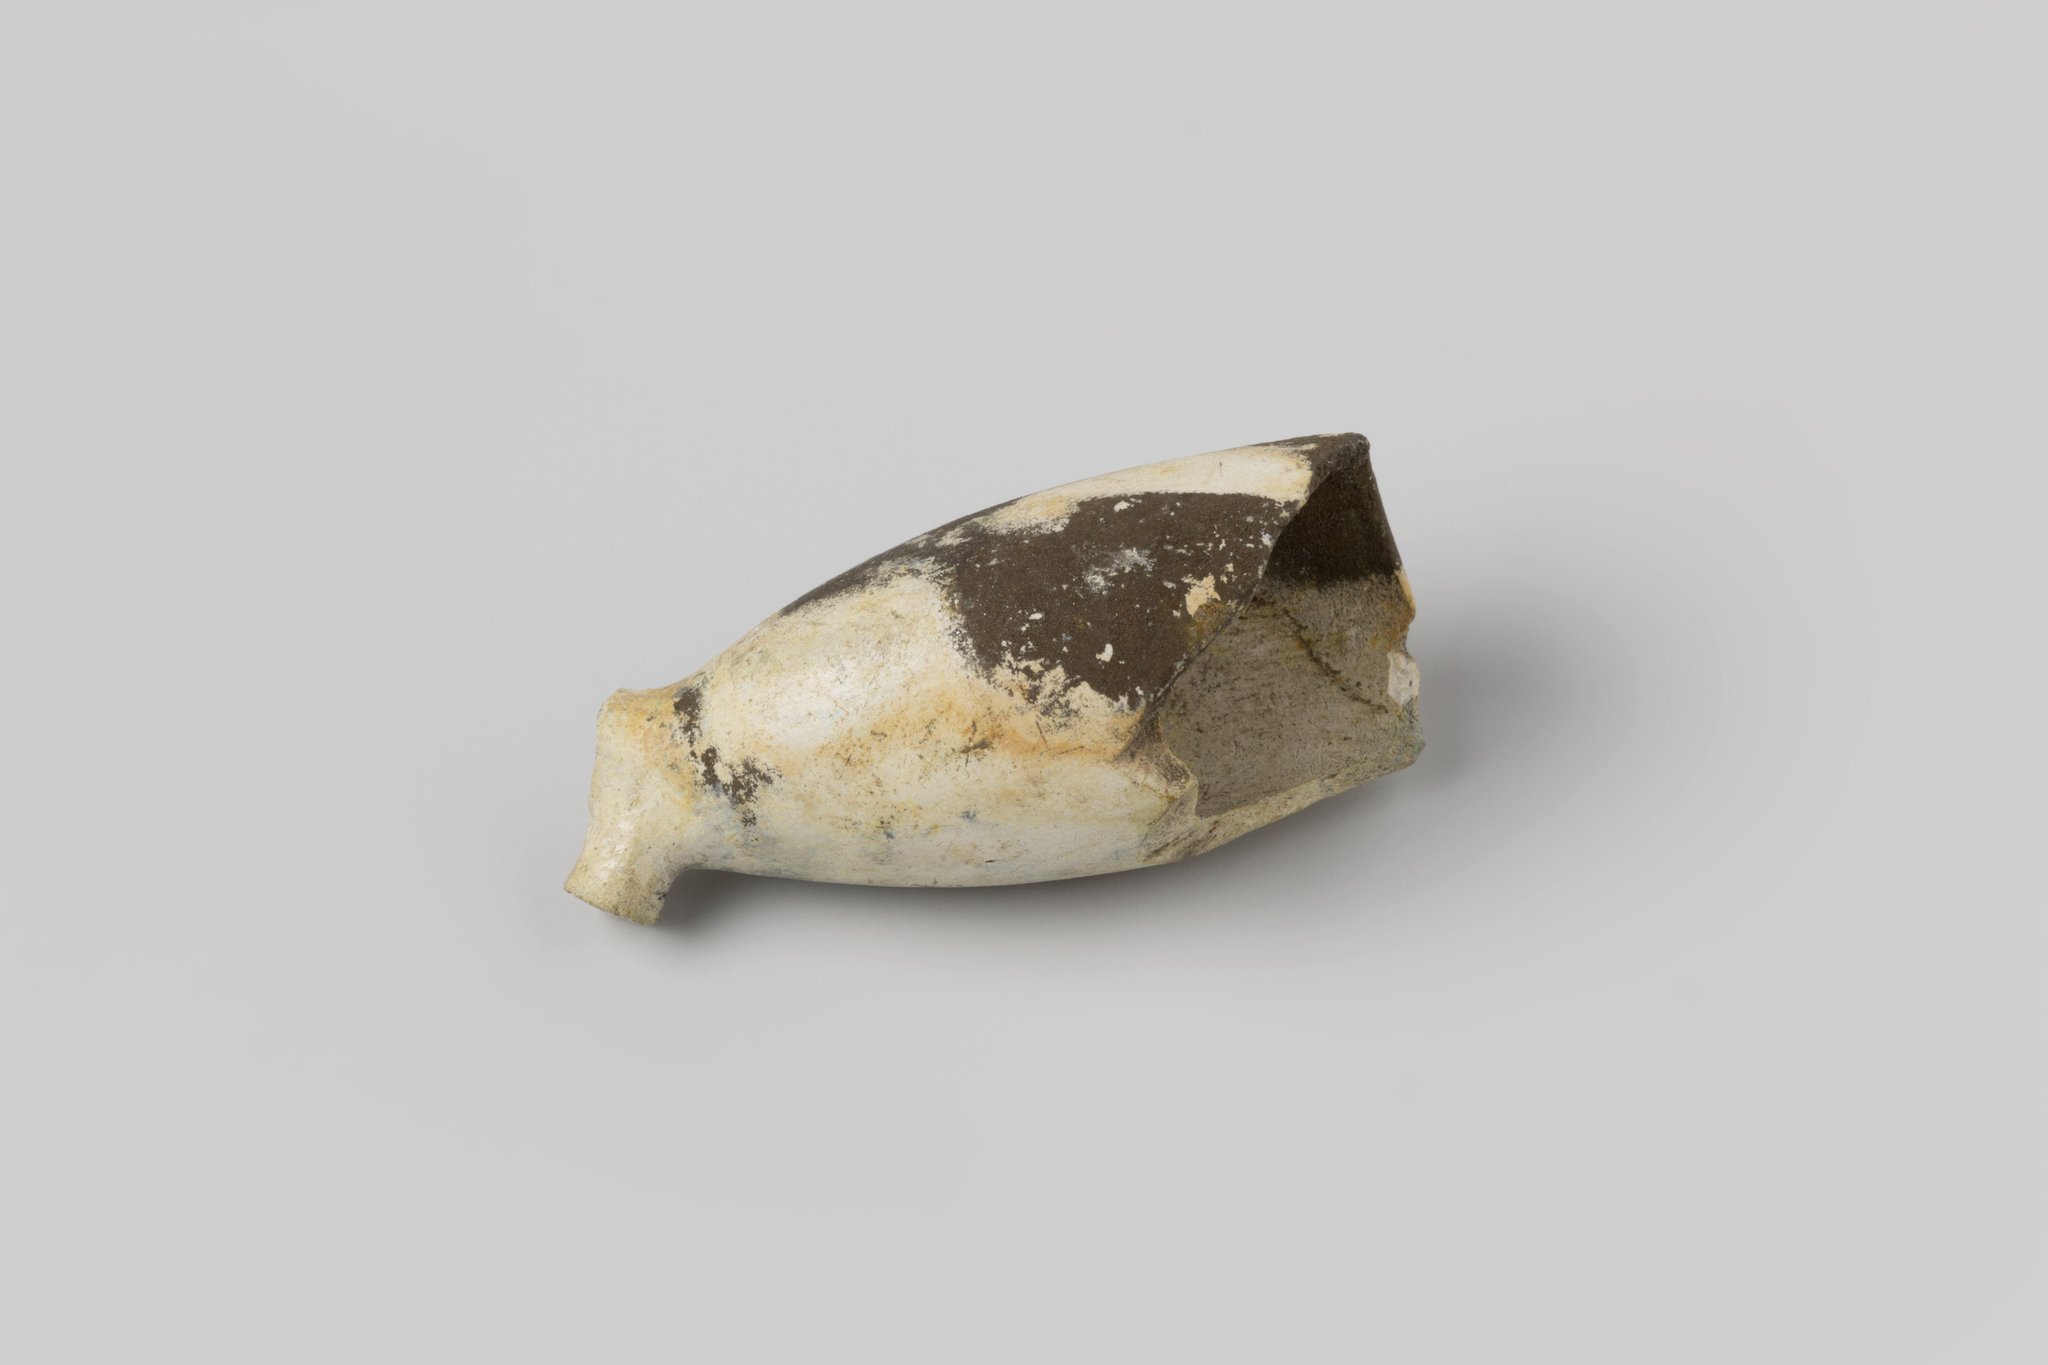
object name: pipe bowl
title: Fragment pijpenkop uit het wrak van de Oost-Indiëvaarder Hollandia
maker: Anonymous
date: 1700-1743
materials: clay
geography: netherlands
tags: verenigde oostindische compagnie, hollandia (schip), annet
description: Pipe, bowl, heelmark: crowned 22; fragm, 1hsm1.